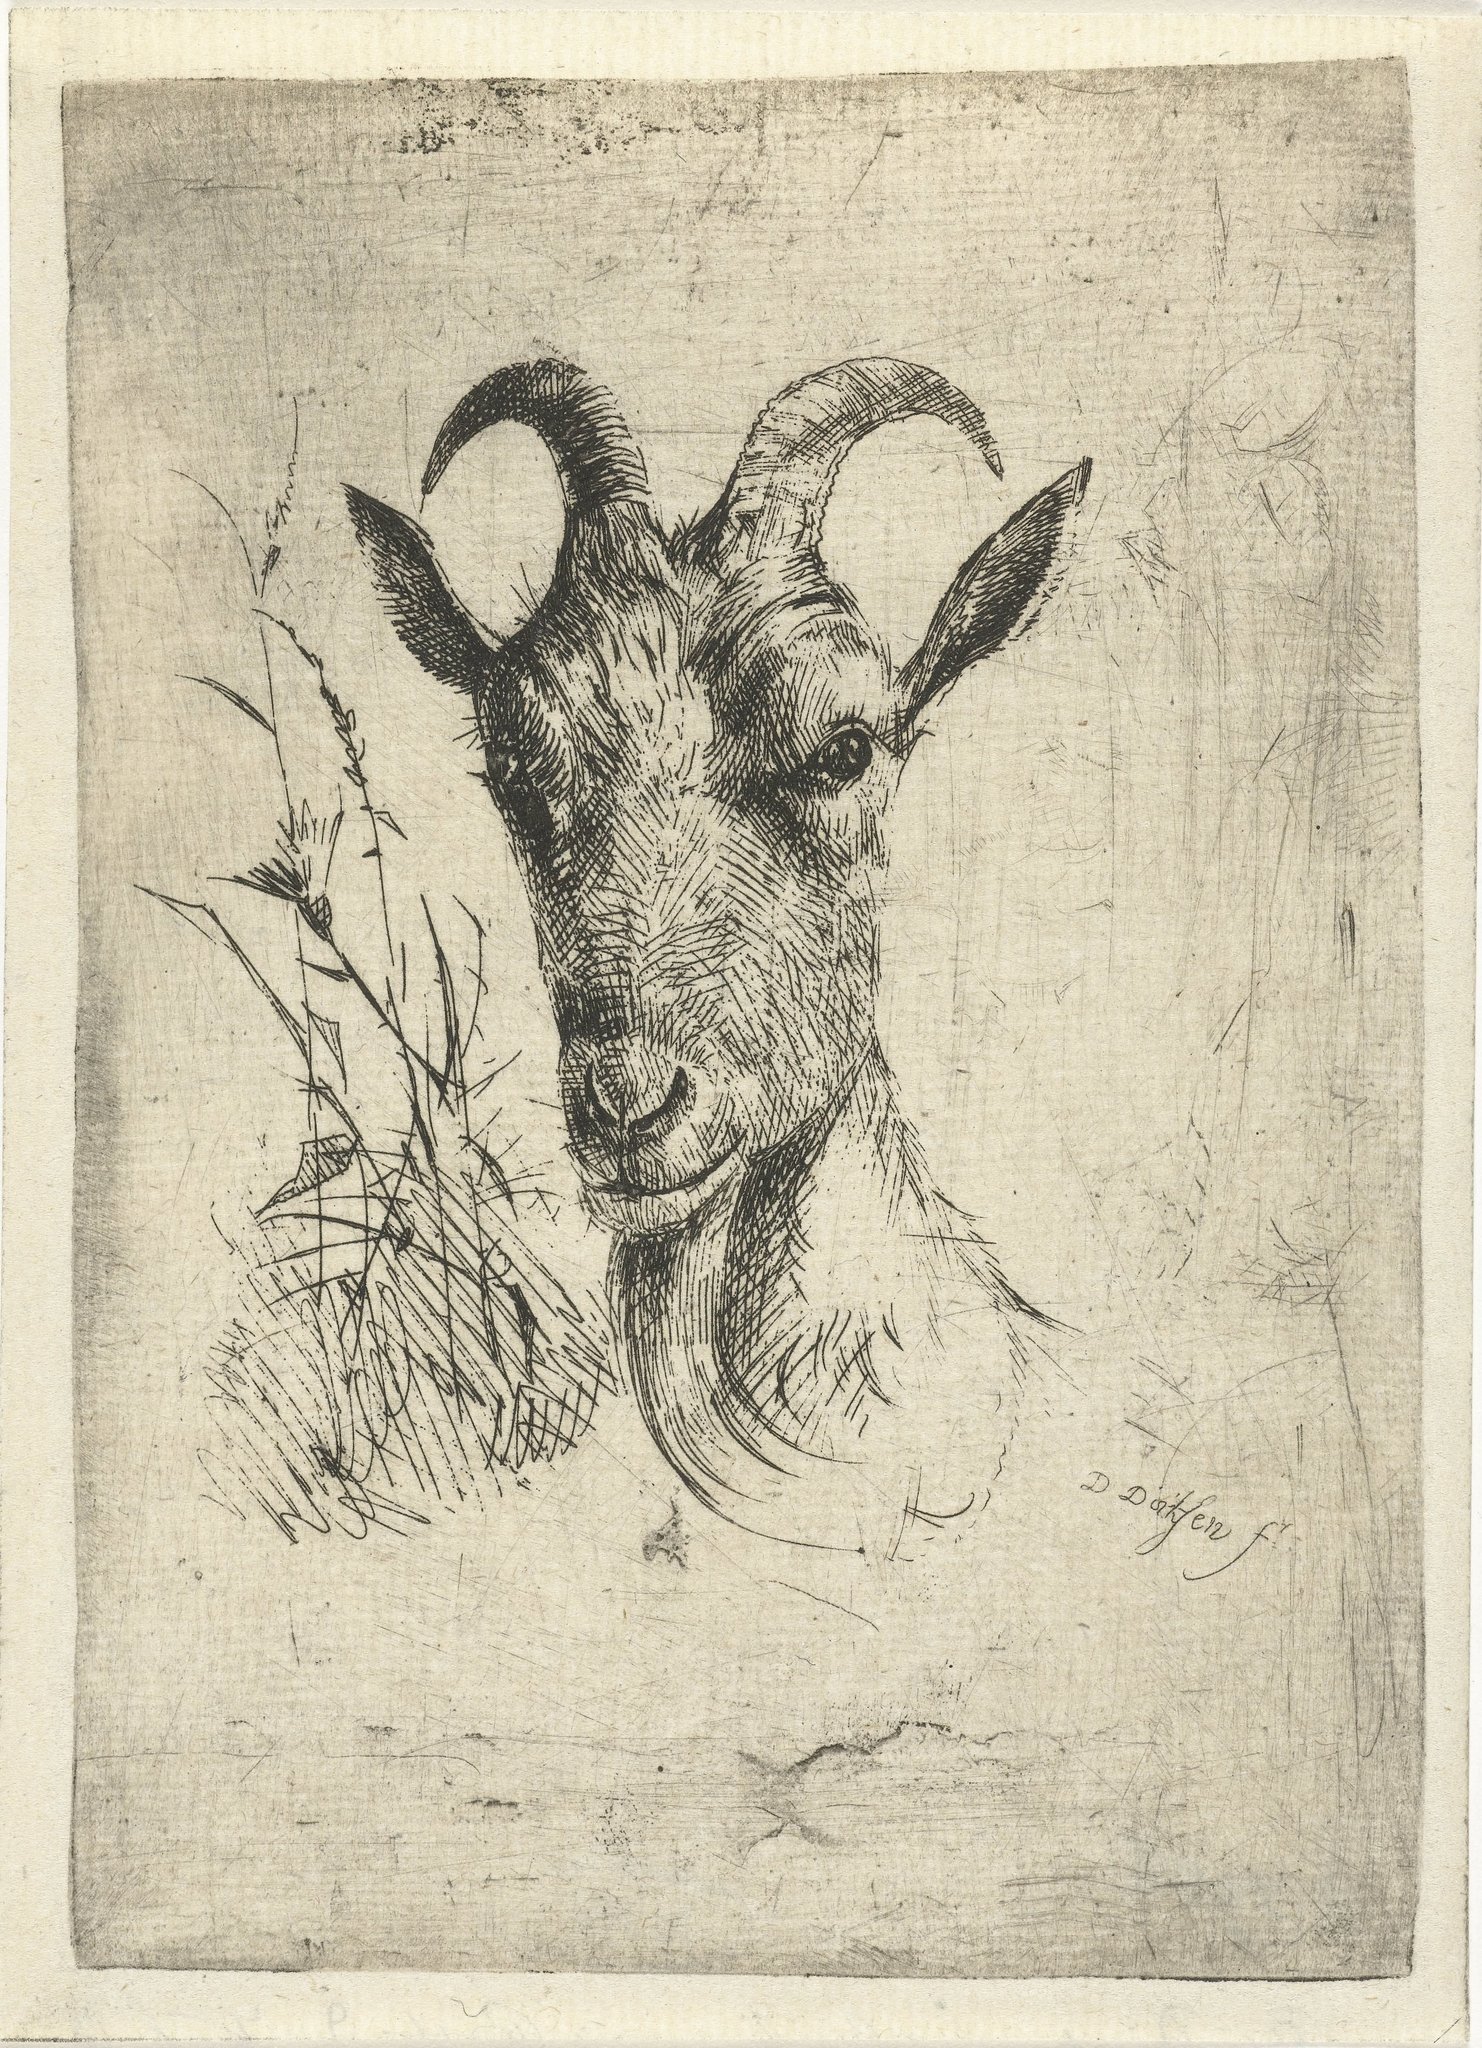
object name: print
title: Kop van geit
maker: dirk dirksen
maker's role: painter, print maker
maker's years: 1811-1885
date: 1821-1882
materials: paper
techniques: etching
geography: rotterdam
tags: goat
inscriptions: collector's mark: Lugt 2228, collector's mark: